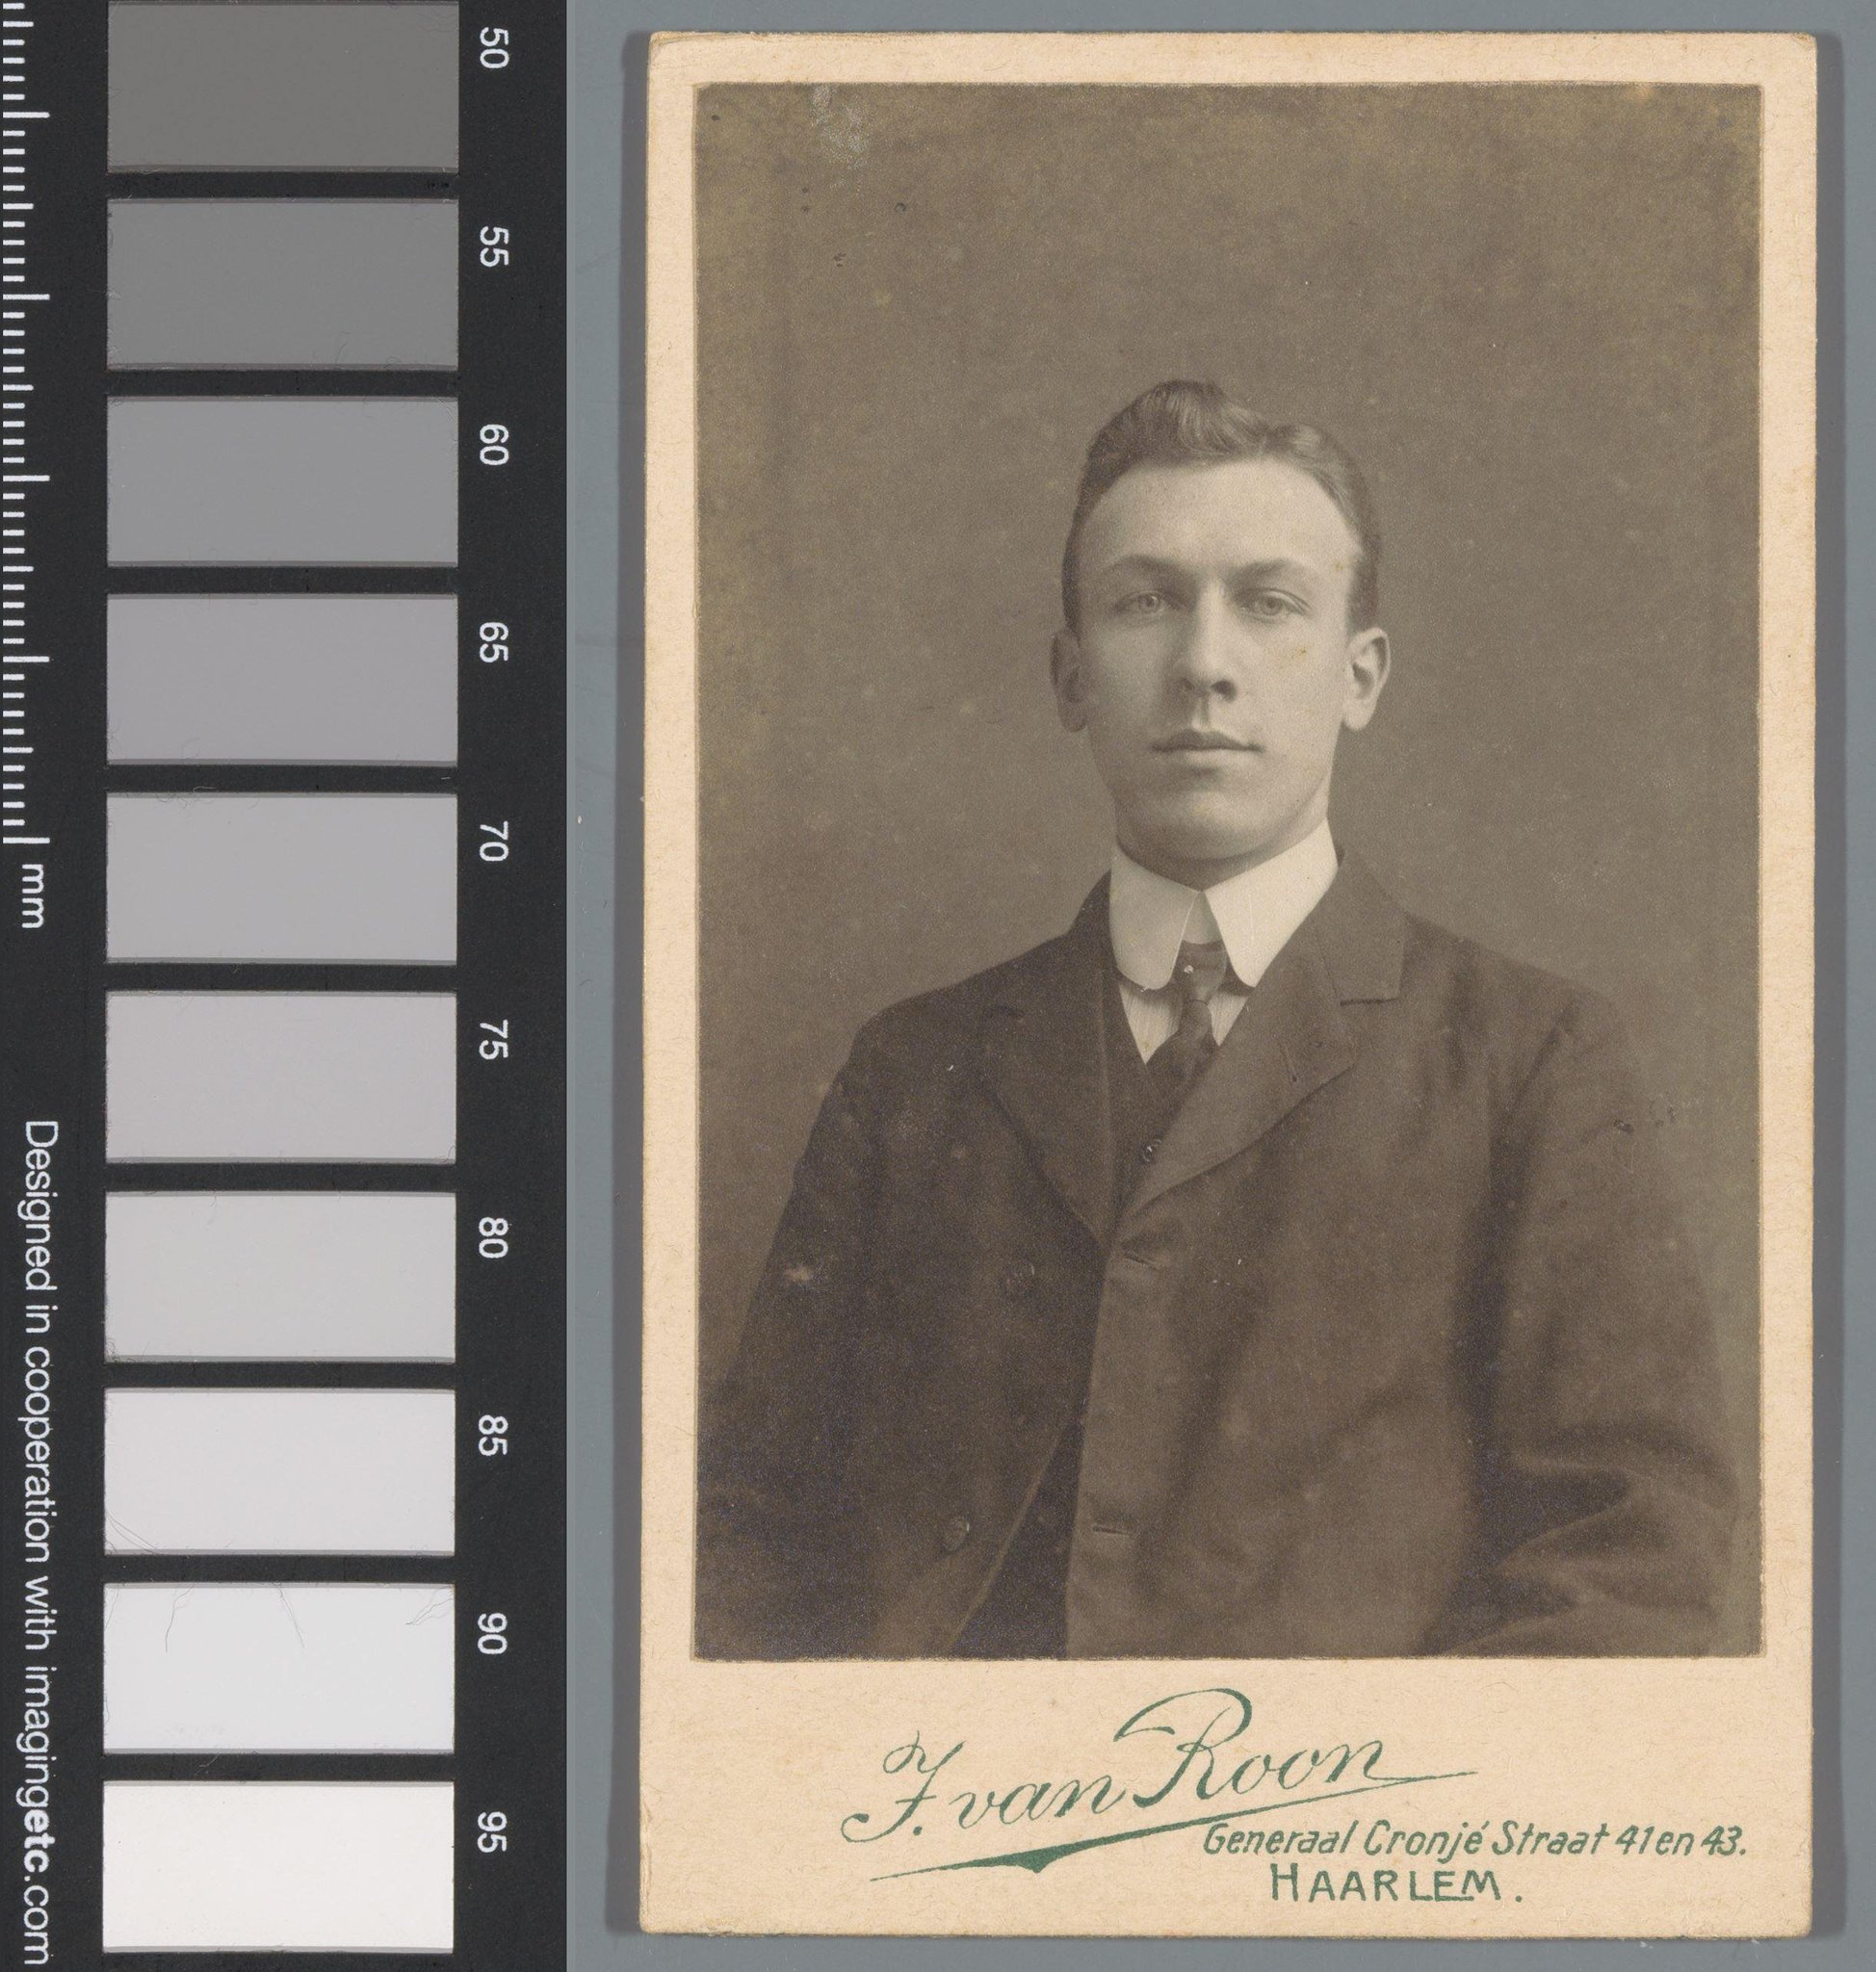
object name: carte de visite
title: Portret van een onbekende man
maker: jan van roon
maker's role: fotograaf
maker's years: 1879-1948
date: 1904-1948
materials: cardboard, photographic support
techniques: gelatin silver print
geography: haarlem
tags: historical persons, youth, adolescent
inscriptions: address: ‘J. van Roon/ Generaal Cronjé Straat 41 en 43./ HAARLEM.’